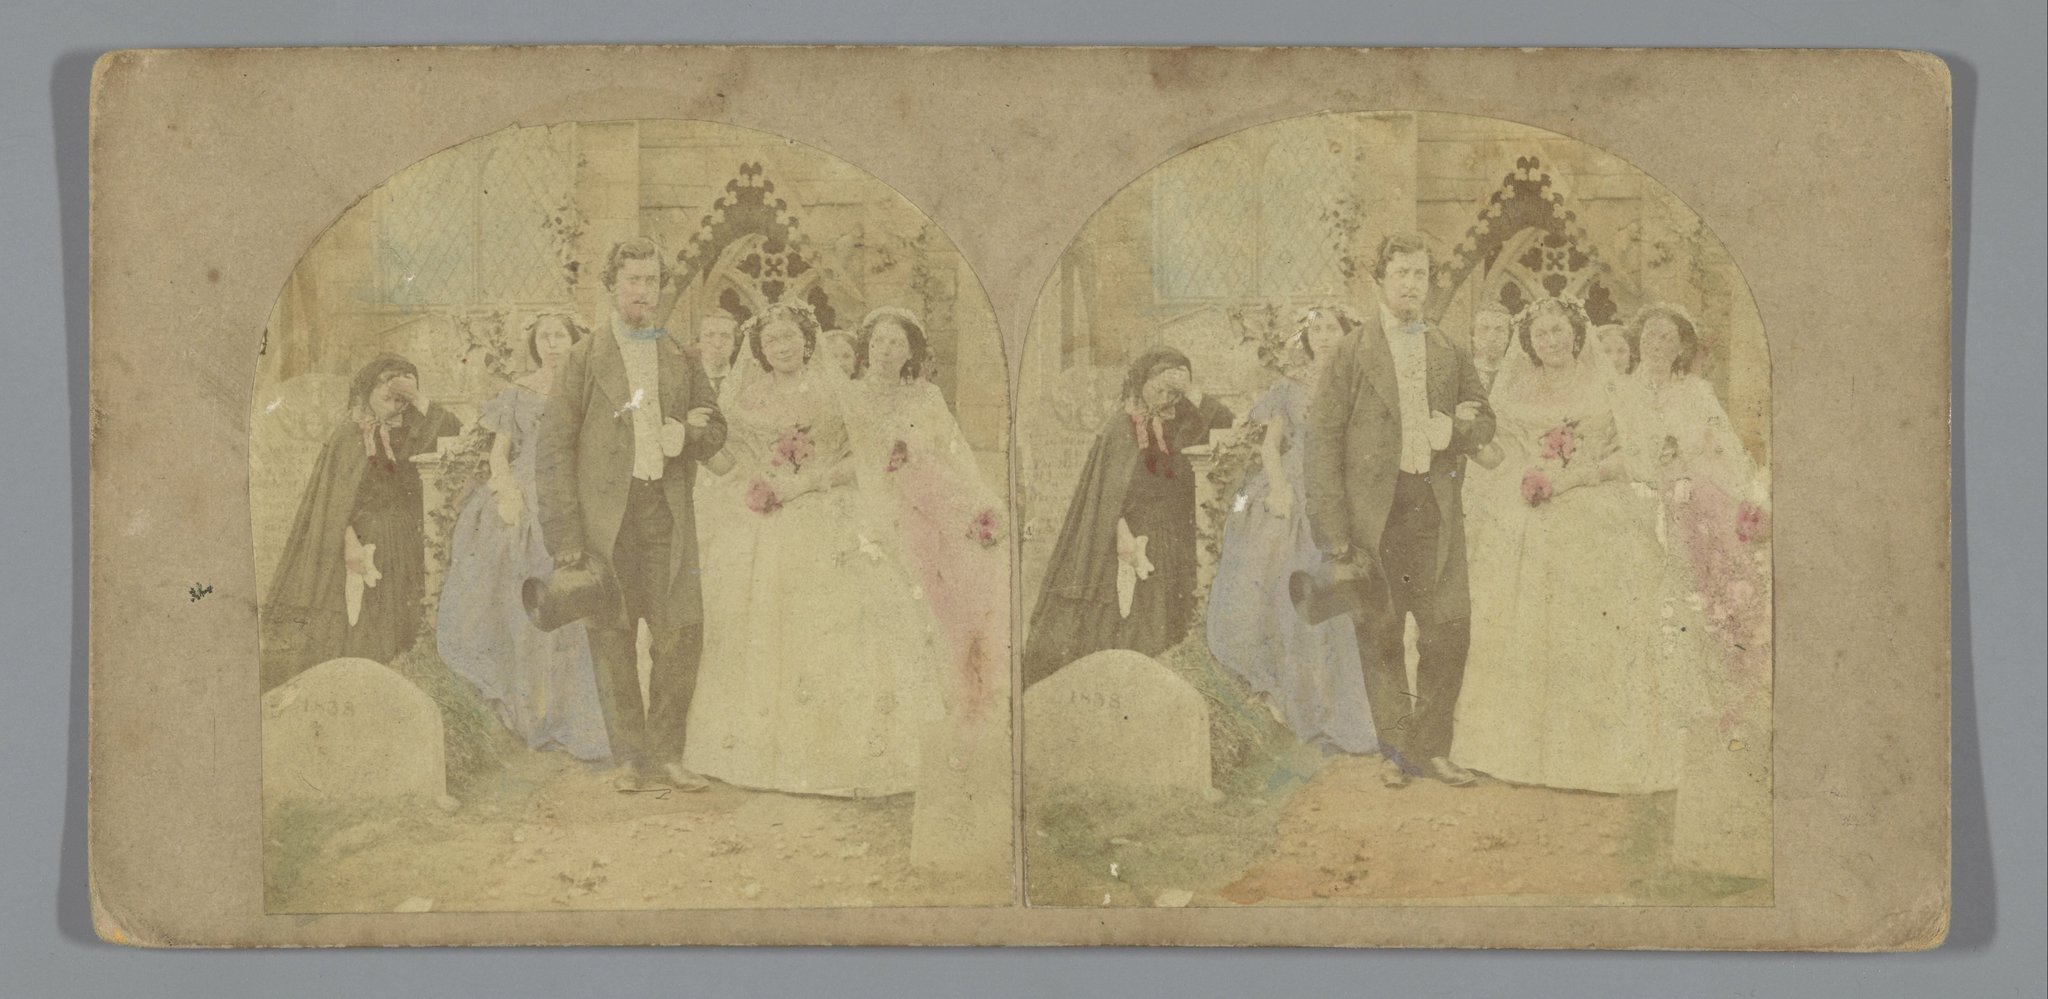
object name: stereograph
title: Bruidspaar op een begraafplaats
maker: Anonymous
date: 1852-1863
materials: cardboard, paper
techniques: albumen print, hand coloring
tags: bride and groom in wedding-dress, churchyard, cemetery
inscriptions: retailer's mark: ‘Nolet & Zoon/ Utrecht’, inscription: ‘M14’